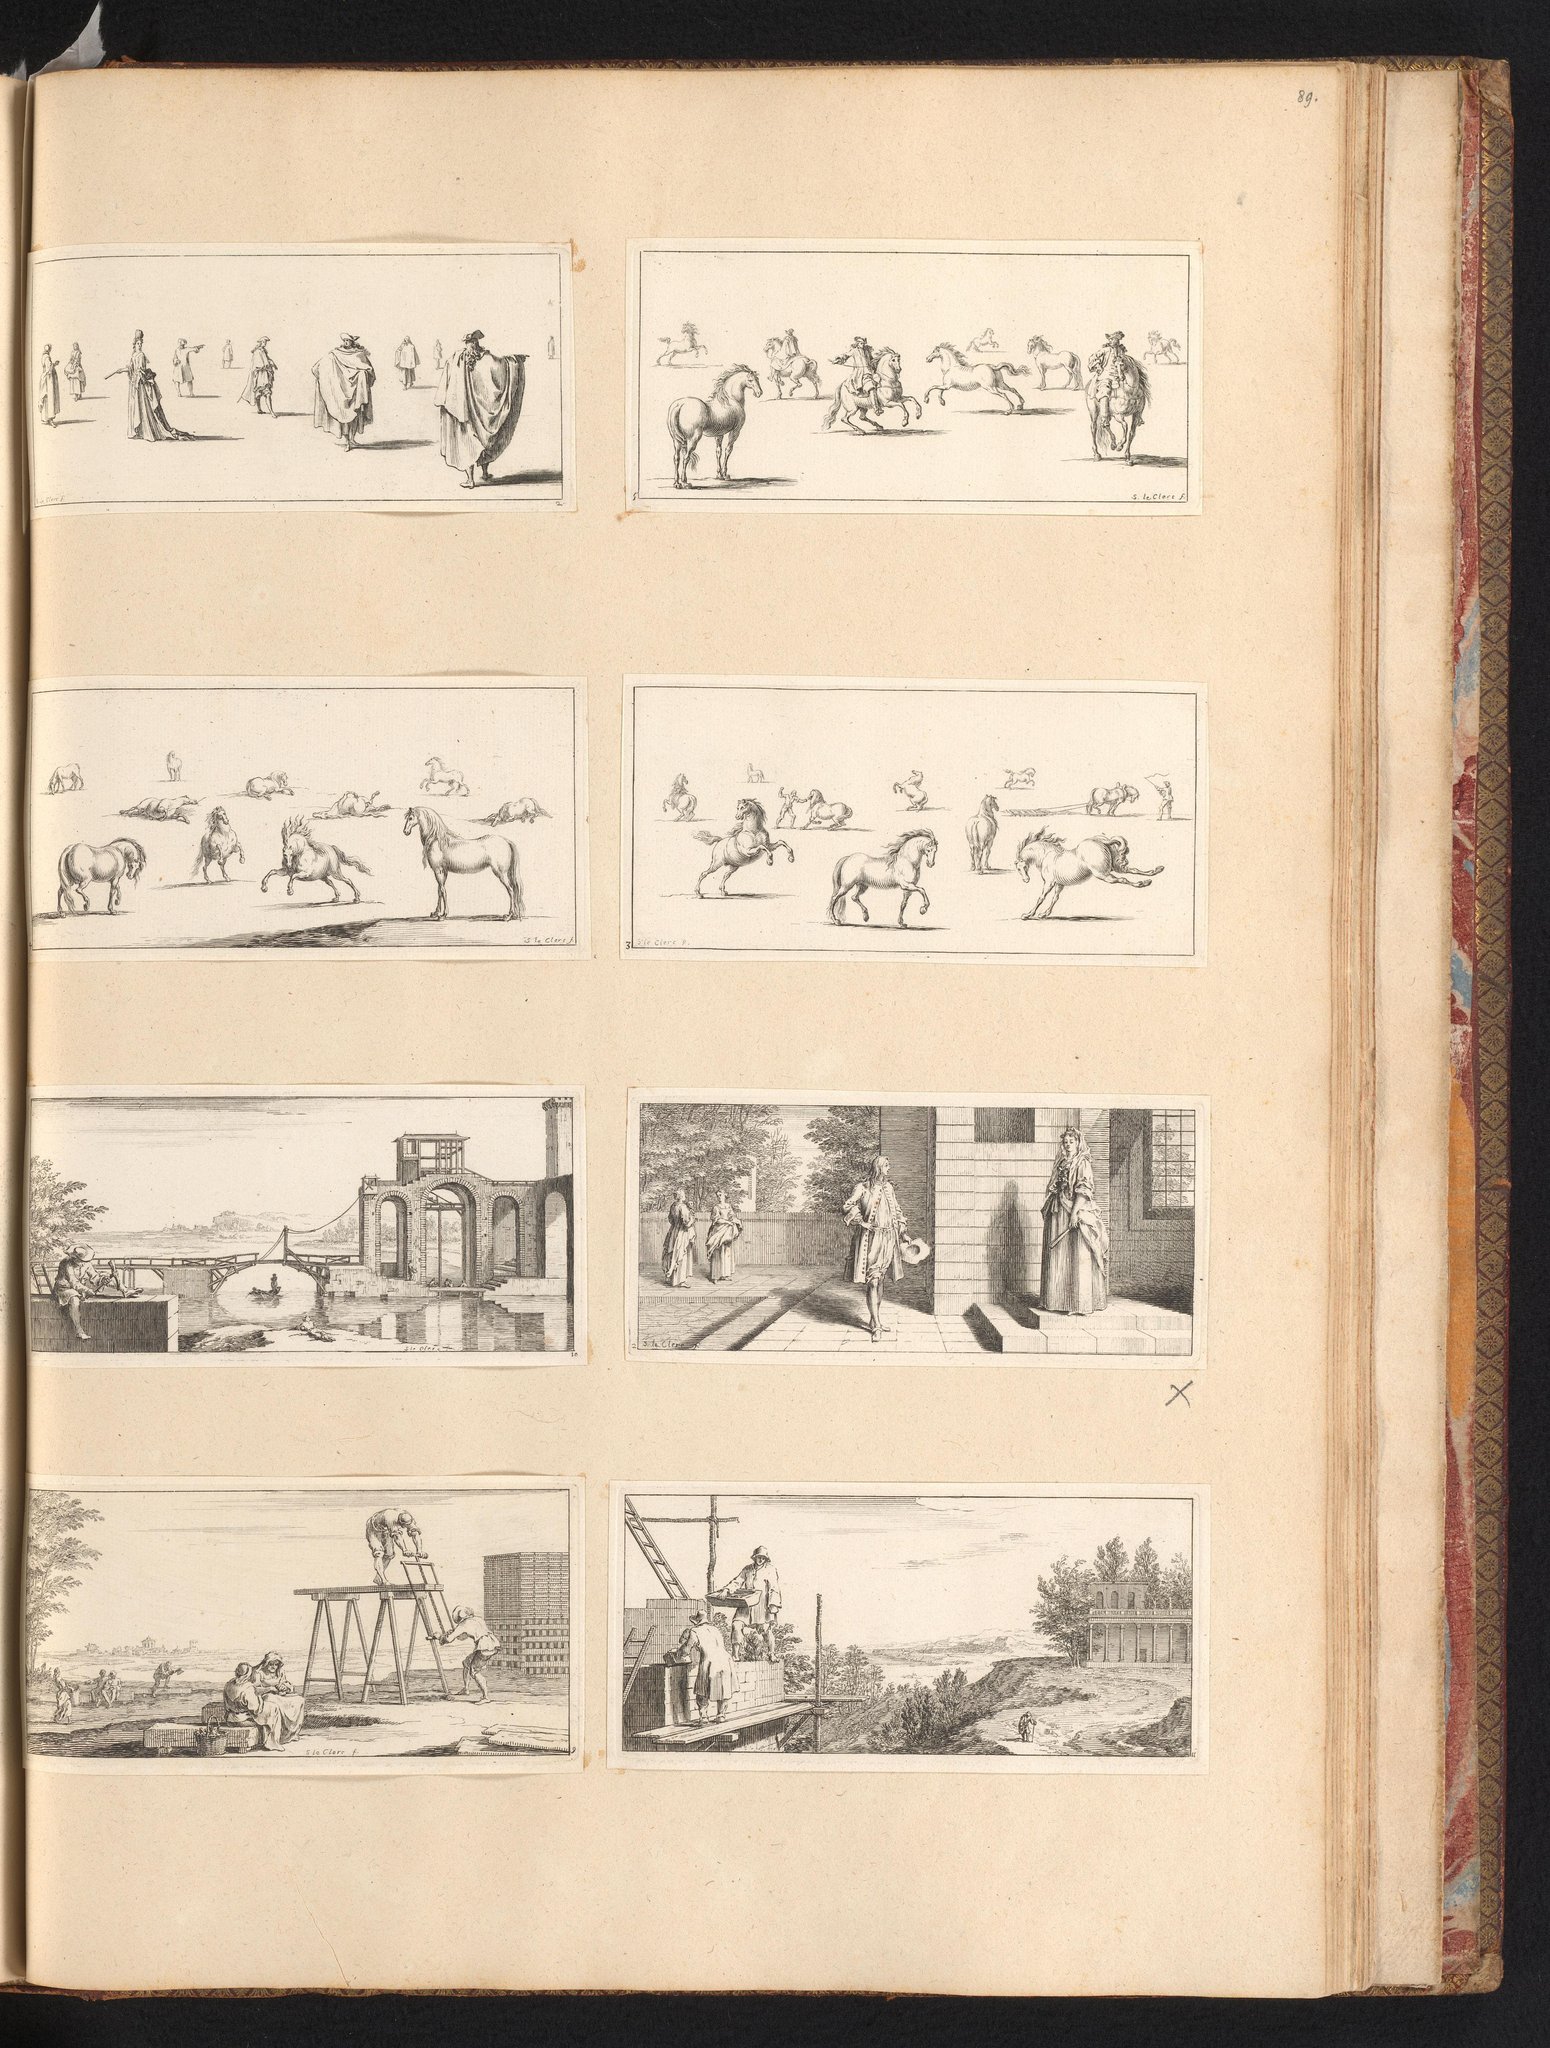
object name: album leaf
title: Quelques Figures Chevaux paysages present's a Monseigneur le Duc de Bourgogne (...)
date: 1696-1700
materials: paper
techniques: etching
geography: france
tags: model-books ~ implements of painter, folk costume, regional costume, horse, building-site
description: Deze prenten maken deel uit van een zestigdelige serie met verschillende reeksen bestaande uit figuren, paarden, landschappen en gebouwen. De serie werd onderverdeeld in negen boeken, waarvan acht boeken met ieder zes prenten en één met twaalf prenten. Leclerc vervaardigde deze reeks voor Lodewijk van Frankrijk om diens tekenles te faciliteren.